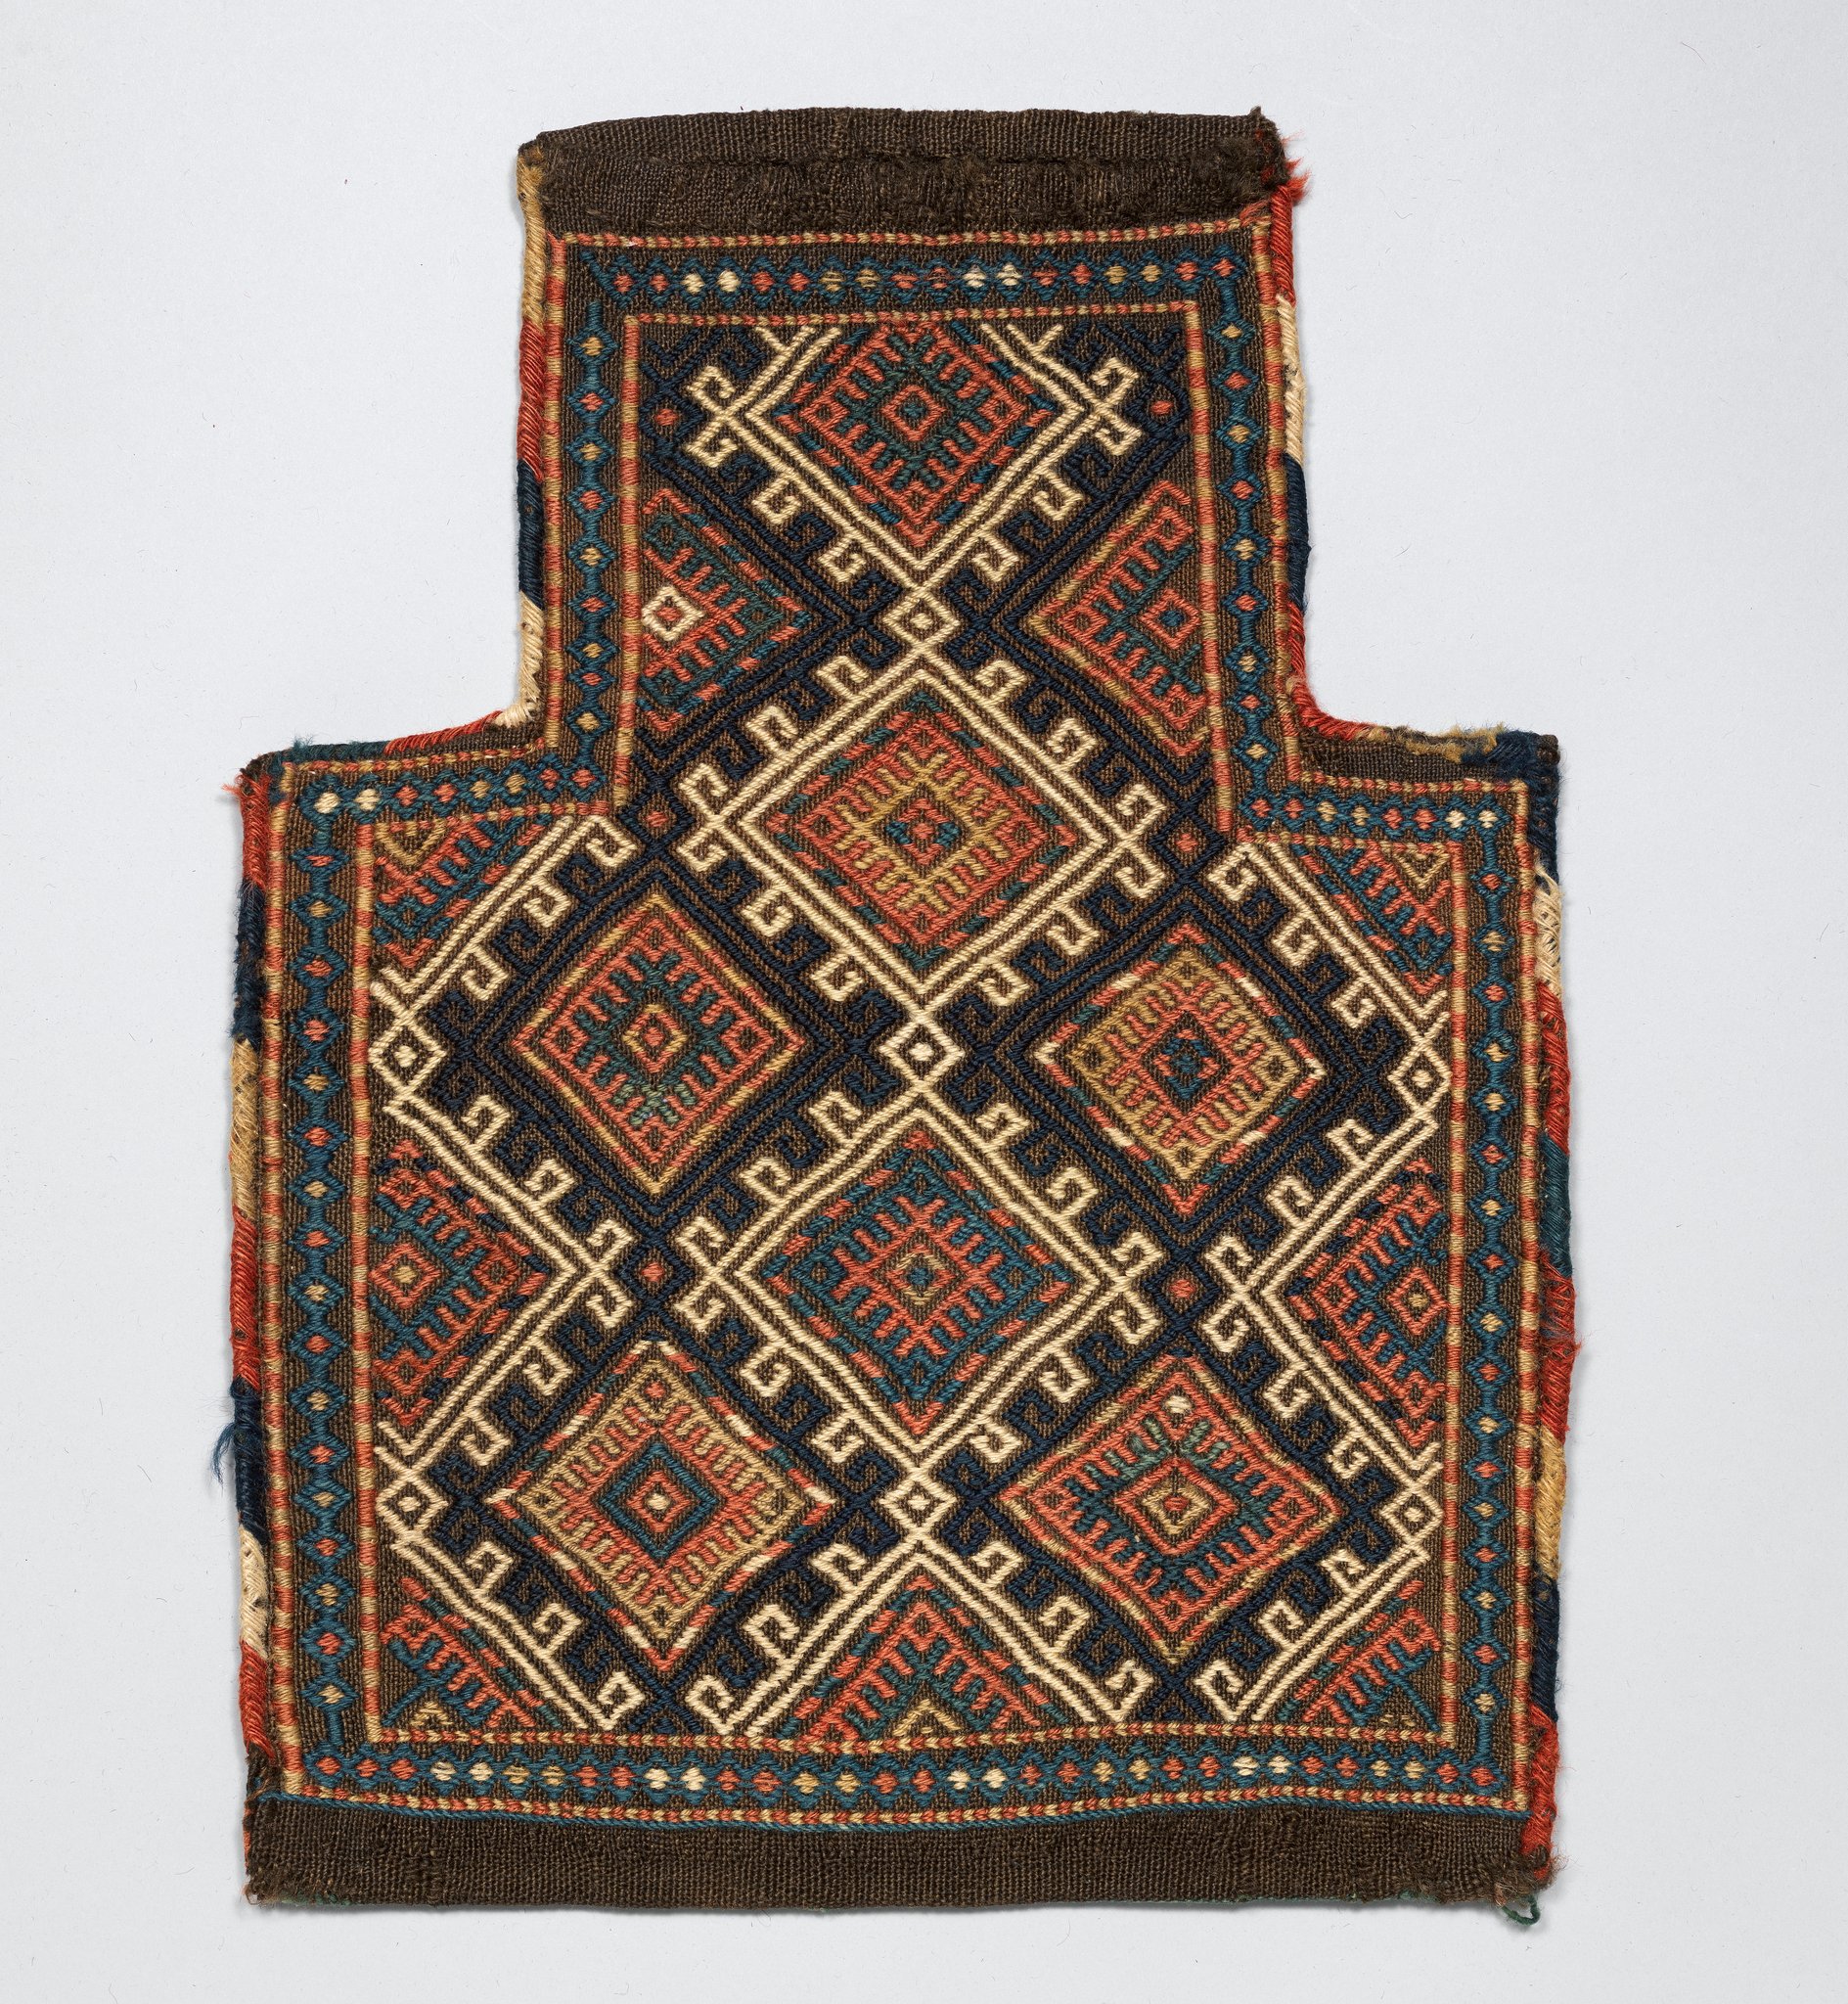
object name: bag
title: Salt Bag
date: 1876-1900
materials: wool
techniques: brocade, weave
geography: western iran